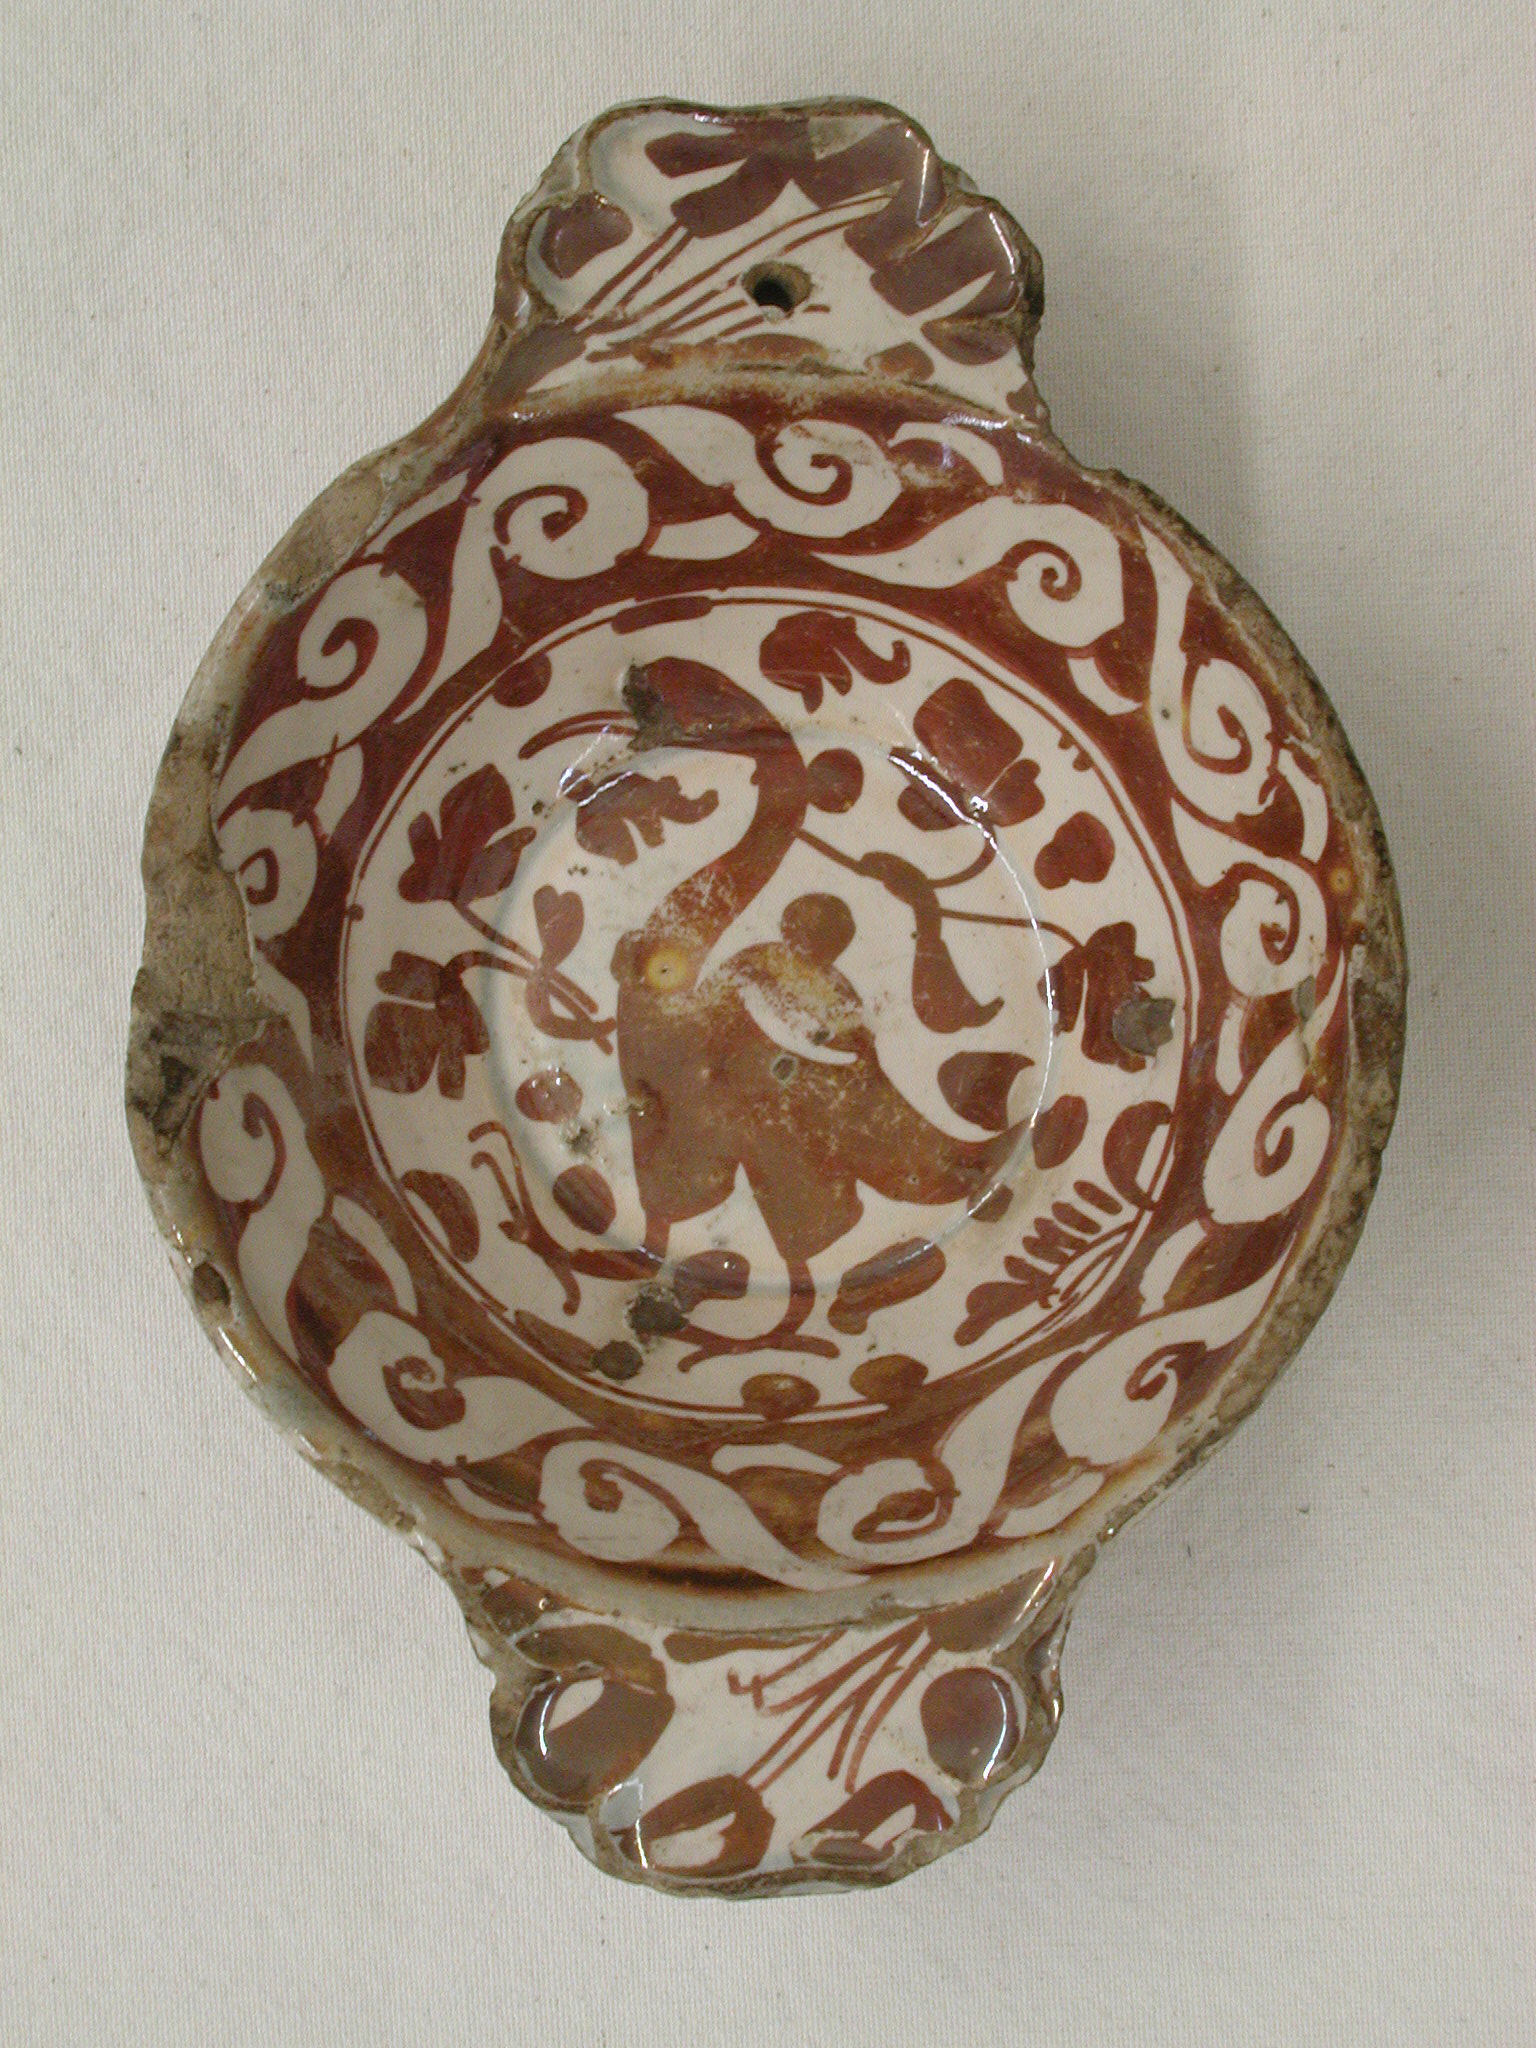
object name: bowl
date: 1601-1700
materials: earthenware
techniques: luster painting, glazing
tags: birds